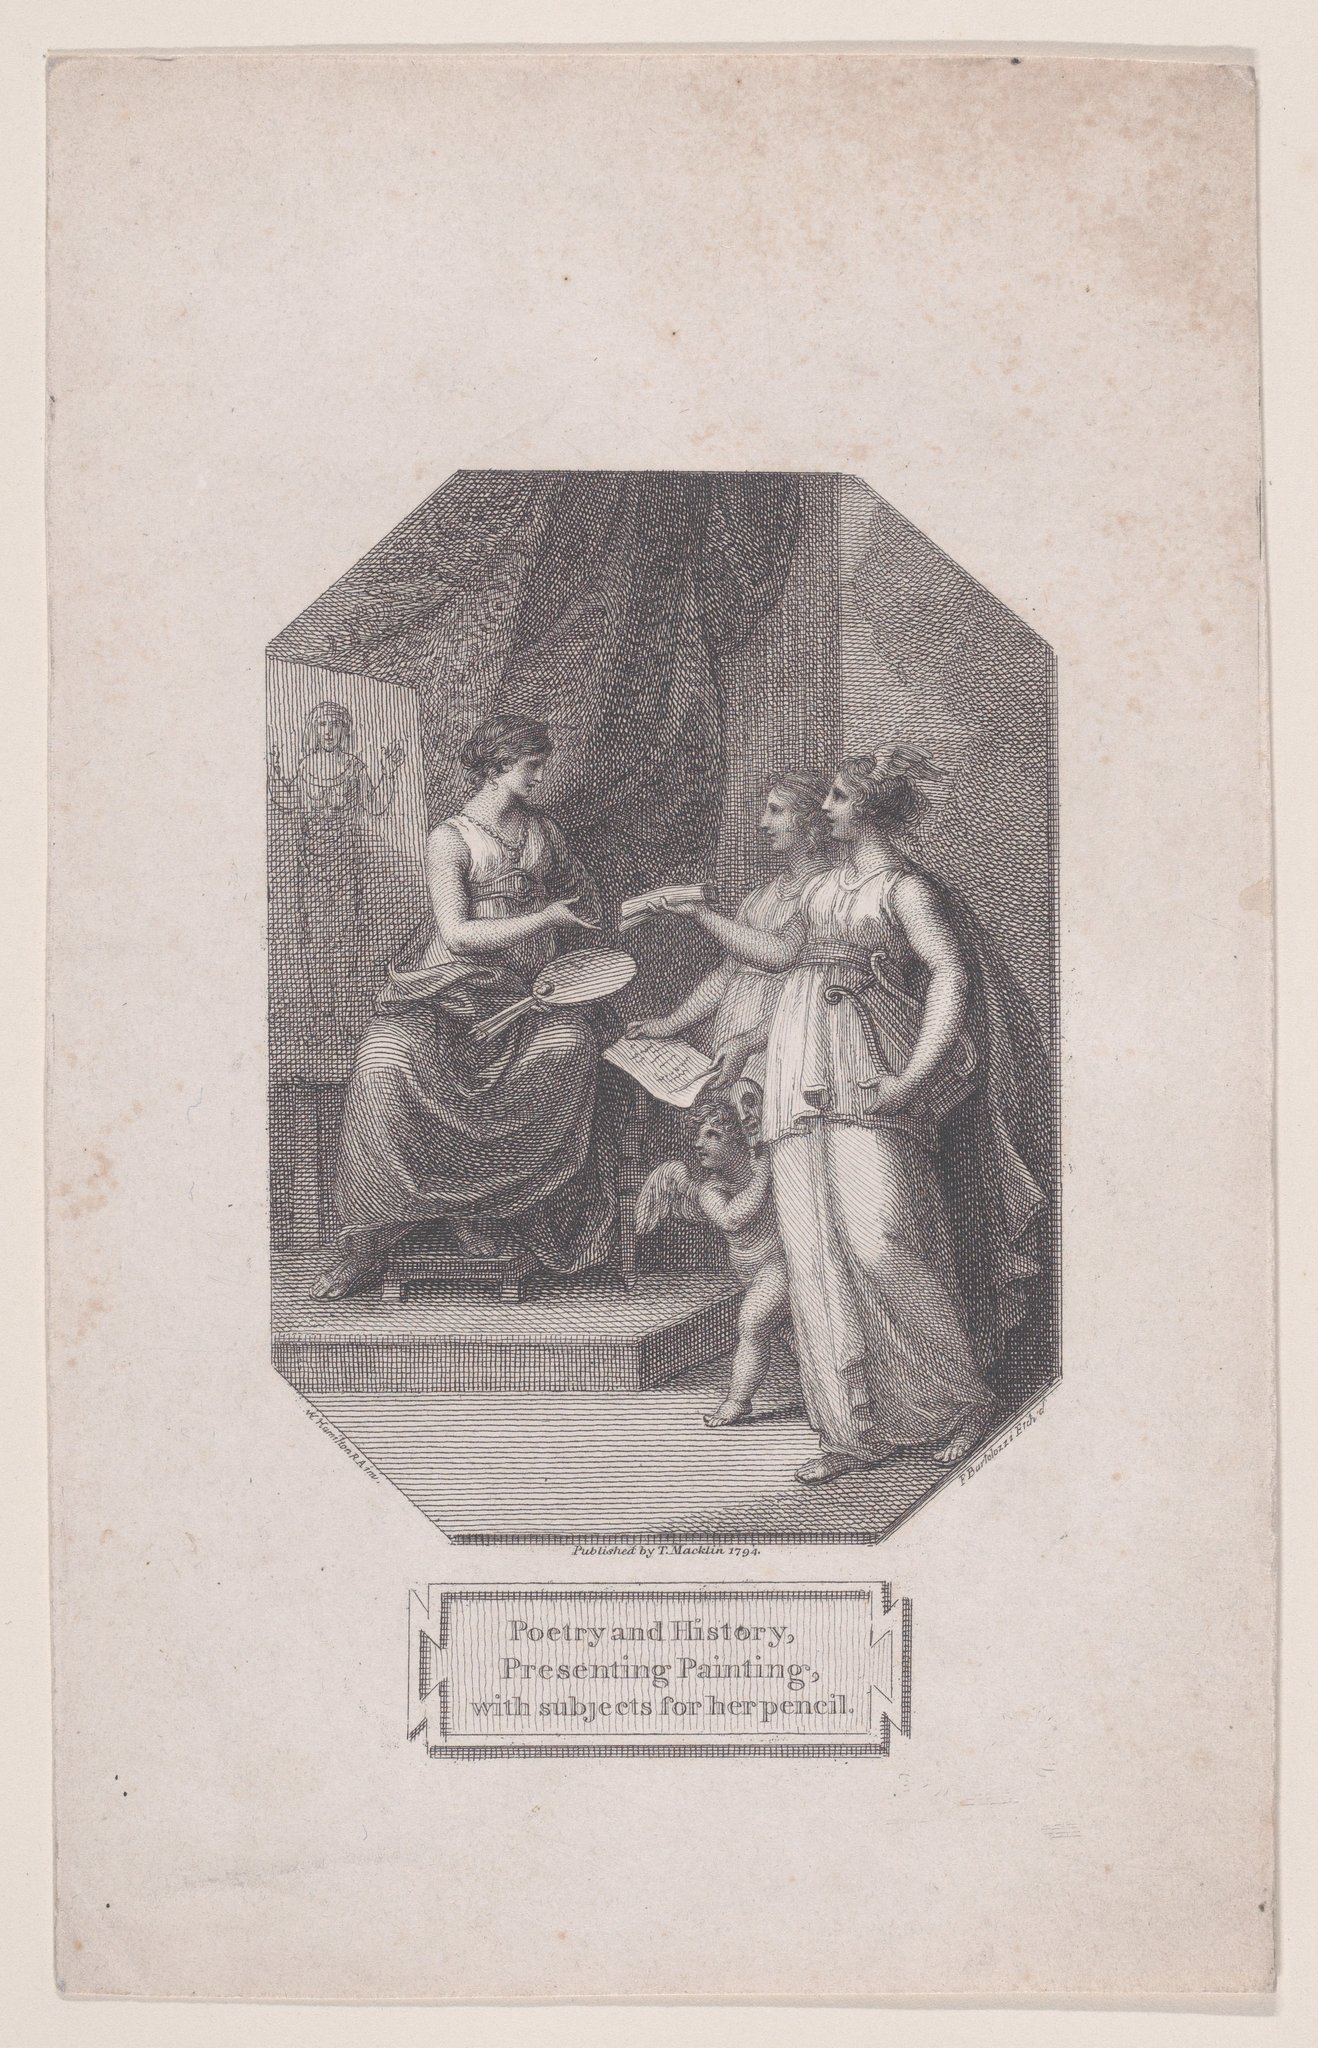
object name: print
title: Poetry and History Presenting Painting with Subjects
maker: francesco bartolozzi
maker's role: artist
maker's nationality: italian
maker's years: 1728-1815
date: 1794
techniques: engraving, etching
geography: england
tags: painting,women,allegory,palettes